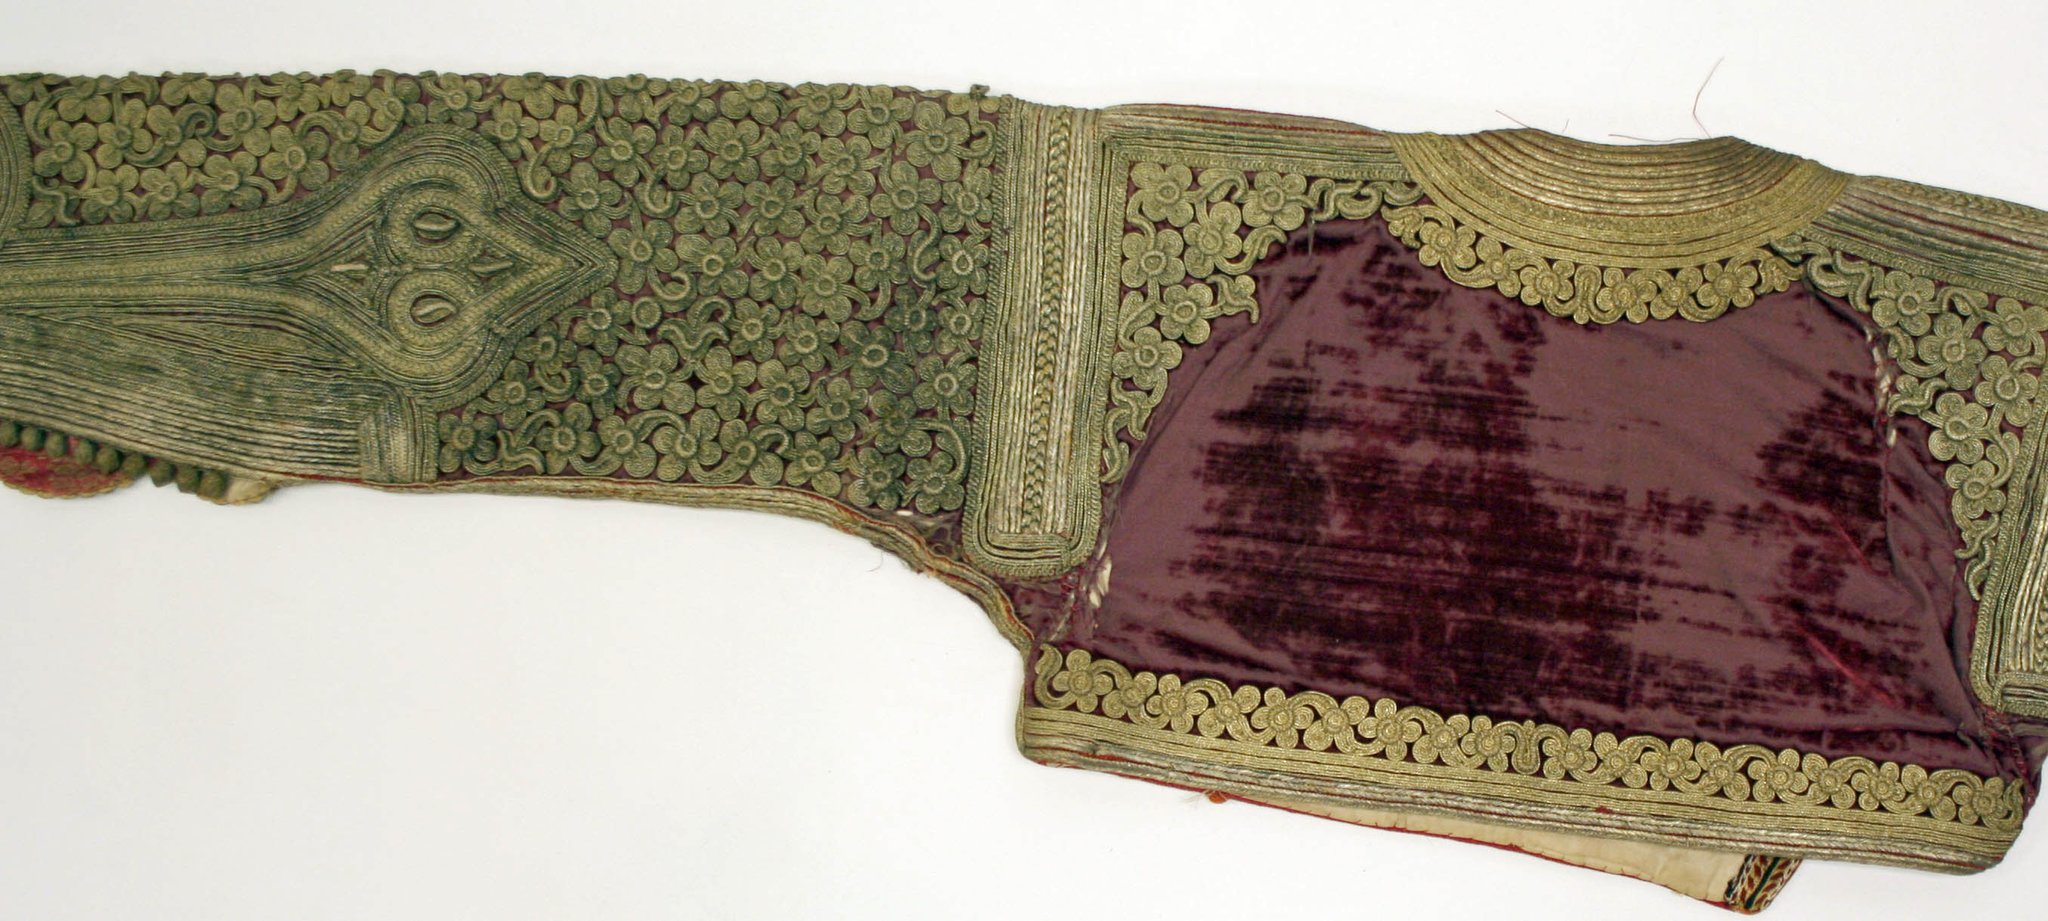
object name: vest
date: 1867-1933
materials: cotton, silk